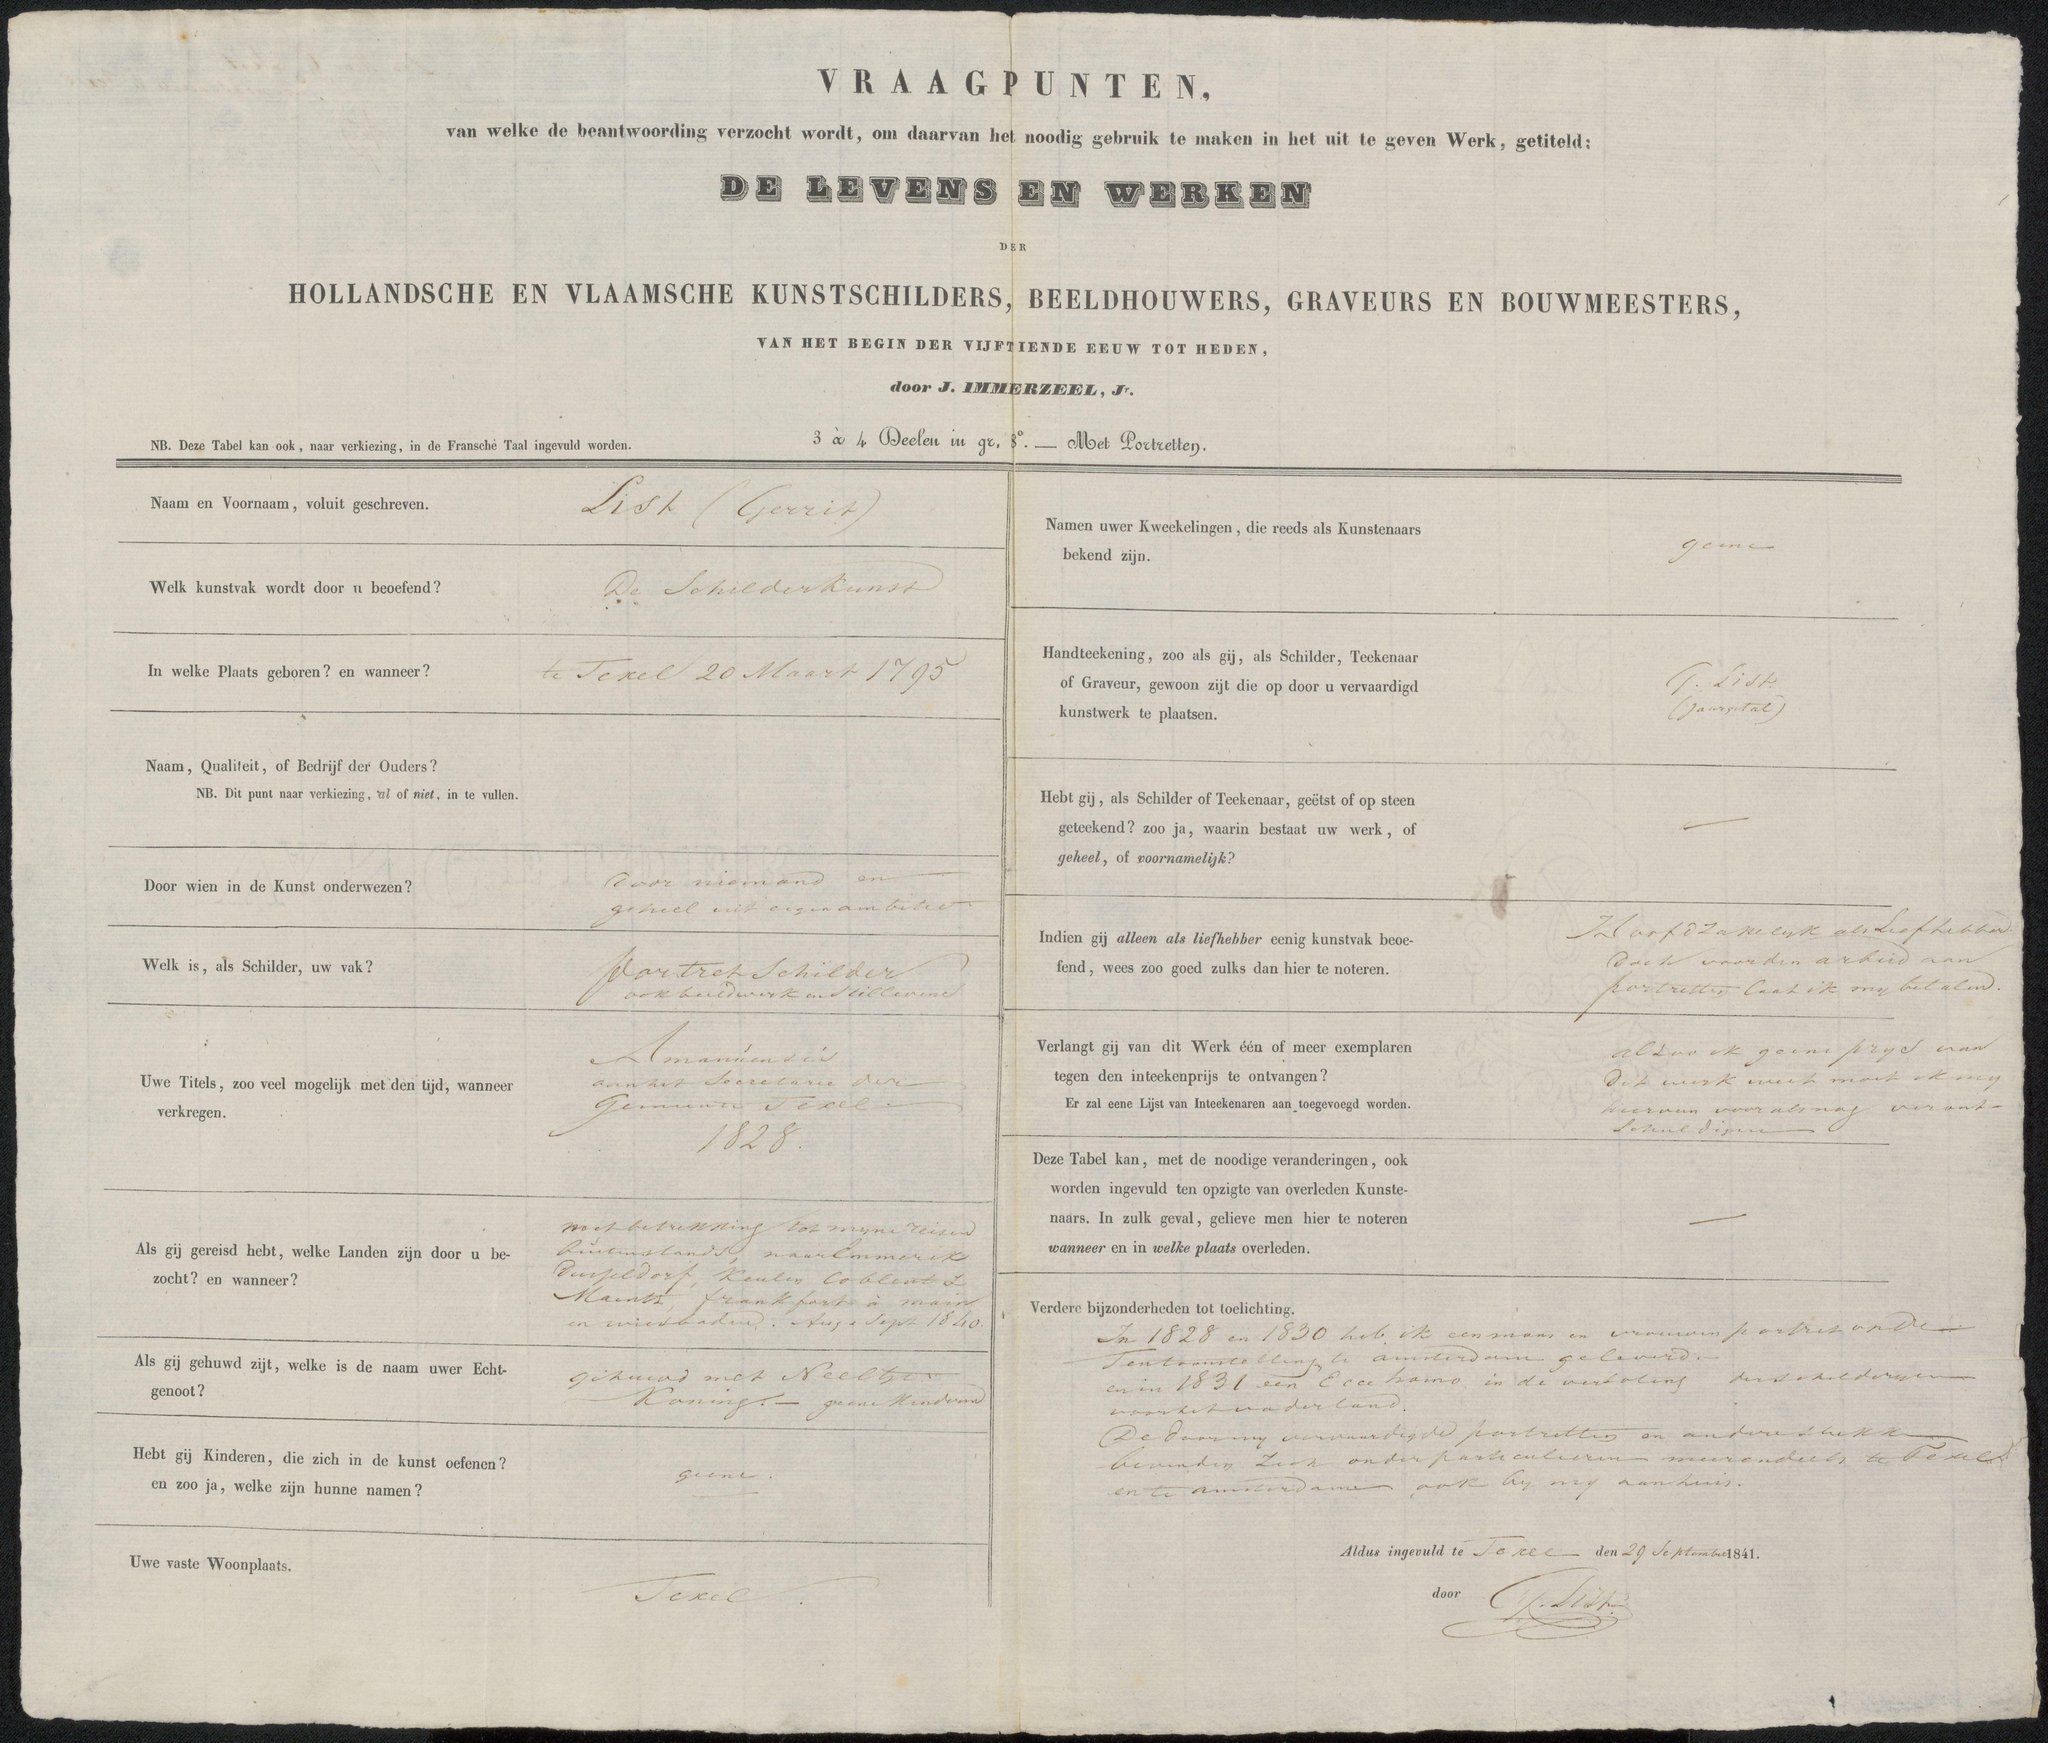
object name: questionnaire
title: Enquêteformulier ingevuld door Gerrit List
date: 1841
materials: ink, paper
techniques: pen, printing, writing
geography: texel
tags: gerrit list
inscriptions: watermark, inscription: ‘Vraagpunten,/ van welke de beantwoording verzocht wordt, om daarvan het noodig gebruik te maken in het uit te geven Werk, getiteld: De levens en werken/ der Hollandsche en Vlaamsche kunstschilders, beeldhouwers,/ graveurs en bouwmeesters, van het begin der vijftiende eeuw tot heden/ door J. Immerzeel, Jr.’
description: Opgenomen in: Immerzeel, J. Jr., De levens en werken der Hollandsche en Vlaamsche kunstschilders, beeldhouwers, graveurs en bouwmeesters, van het begin der vijftiende eeuw tot heden, Amsterdam: J.C. van Kesteren, 1842-1843.